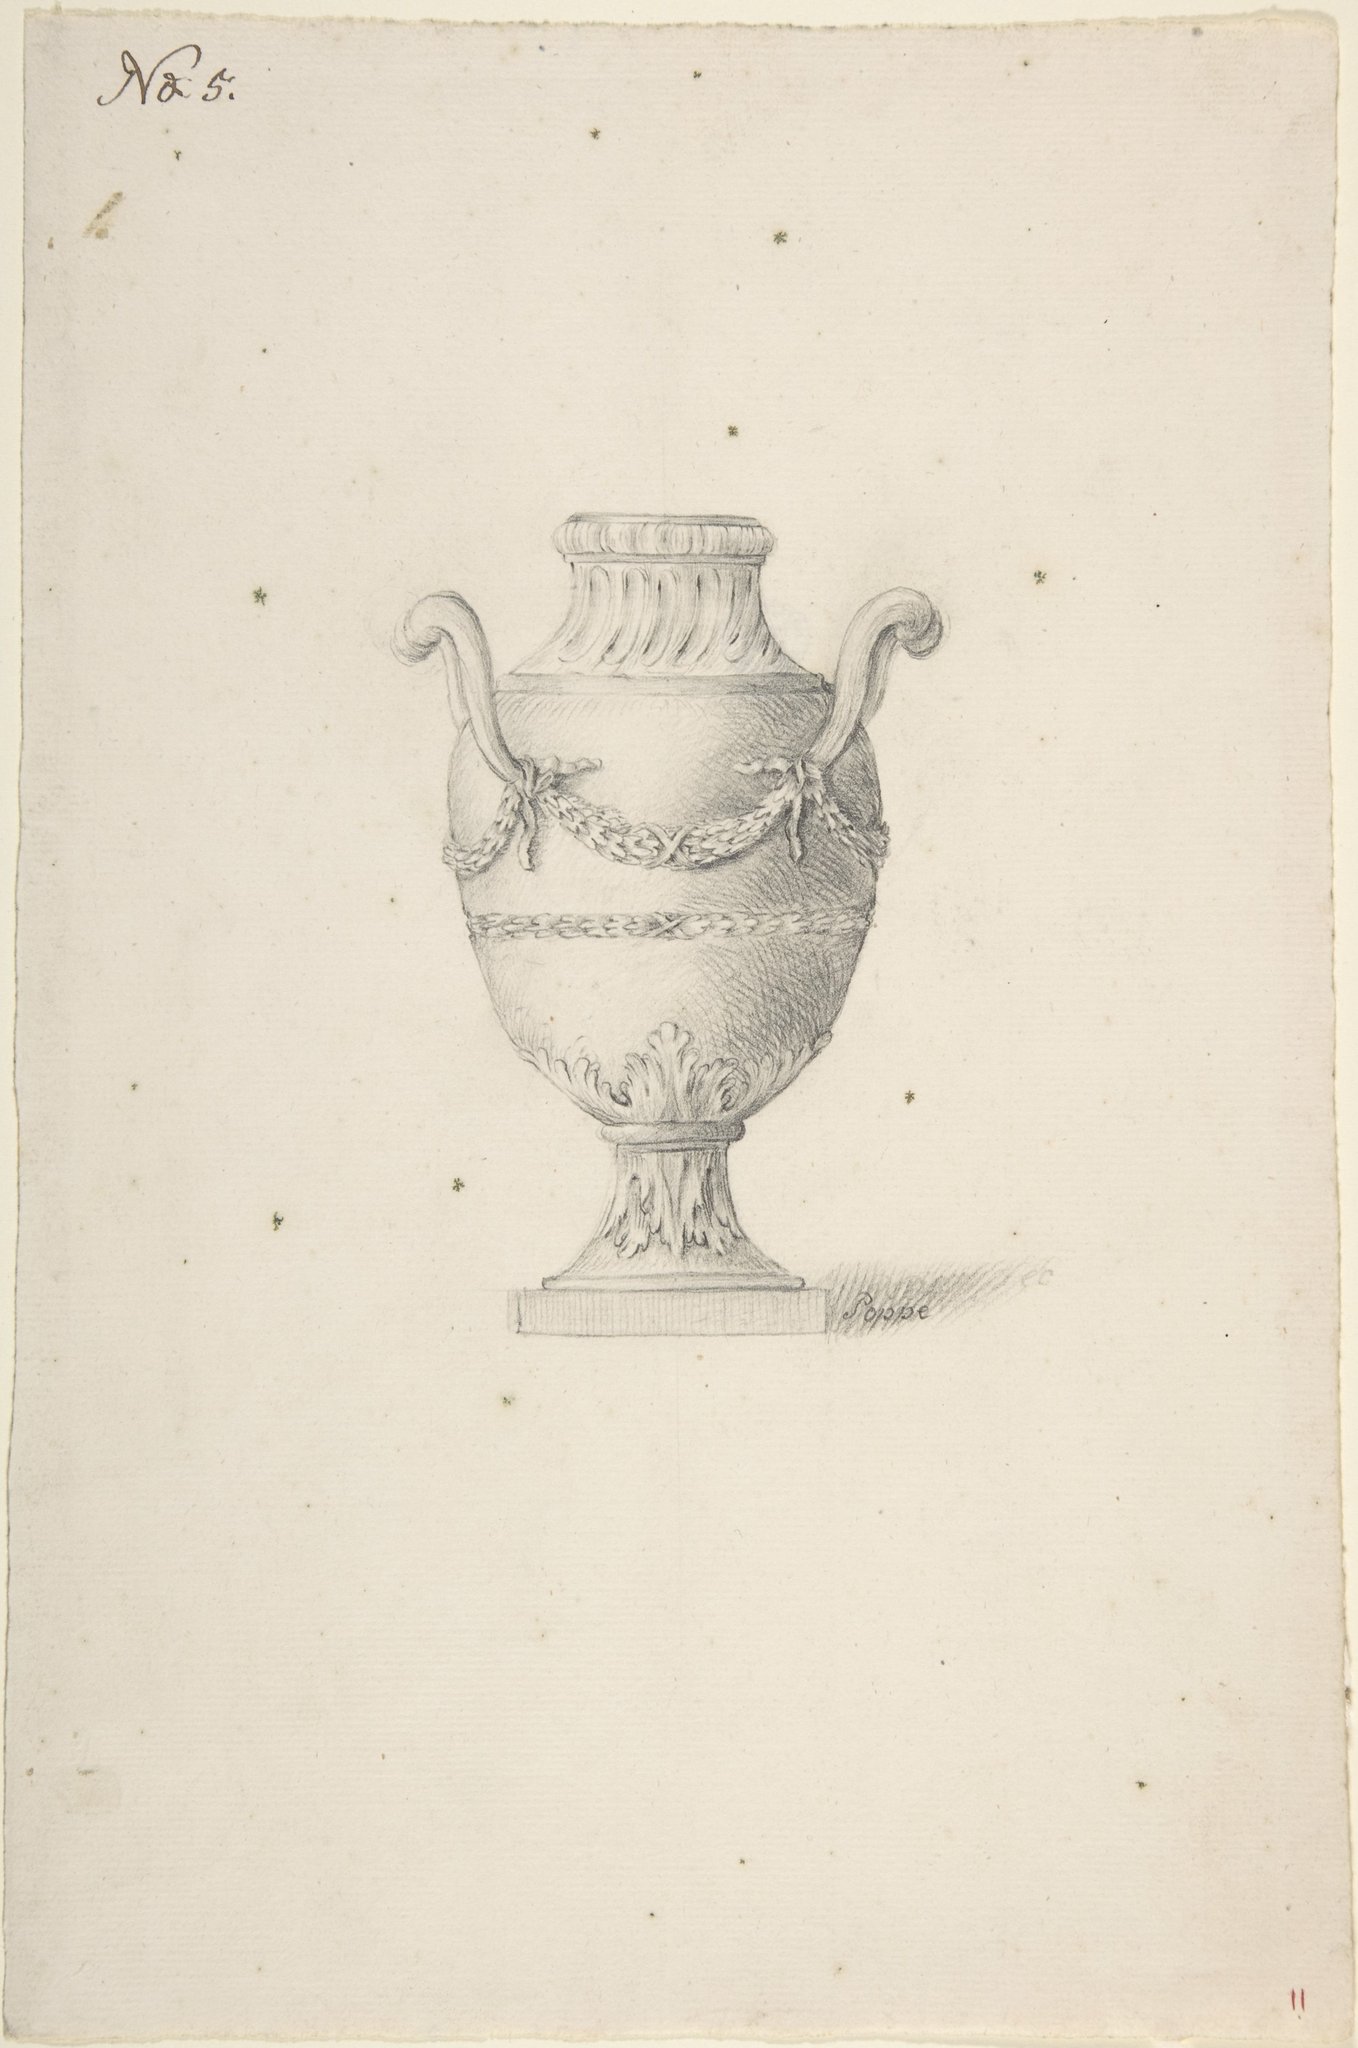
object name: drawing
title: Design for an Urn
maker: anonymous, french, 18th century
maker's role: artist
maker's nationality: french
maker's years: 1700-1800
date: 1770-1790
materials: graphite, ink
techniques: pen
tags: urns